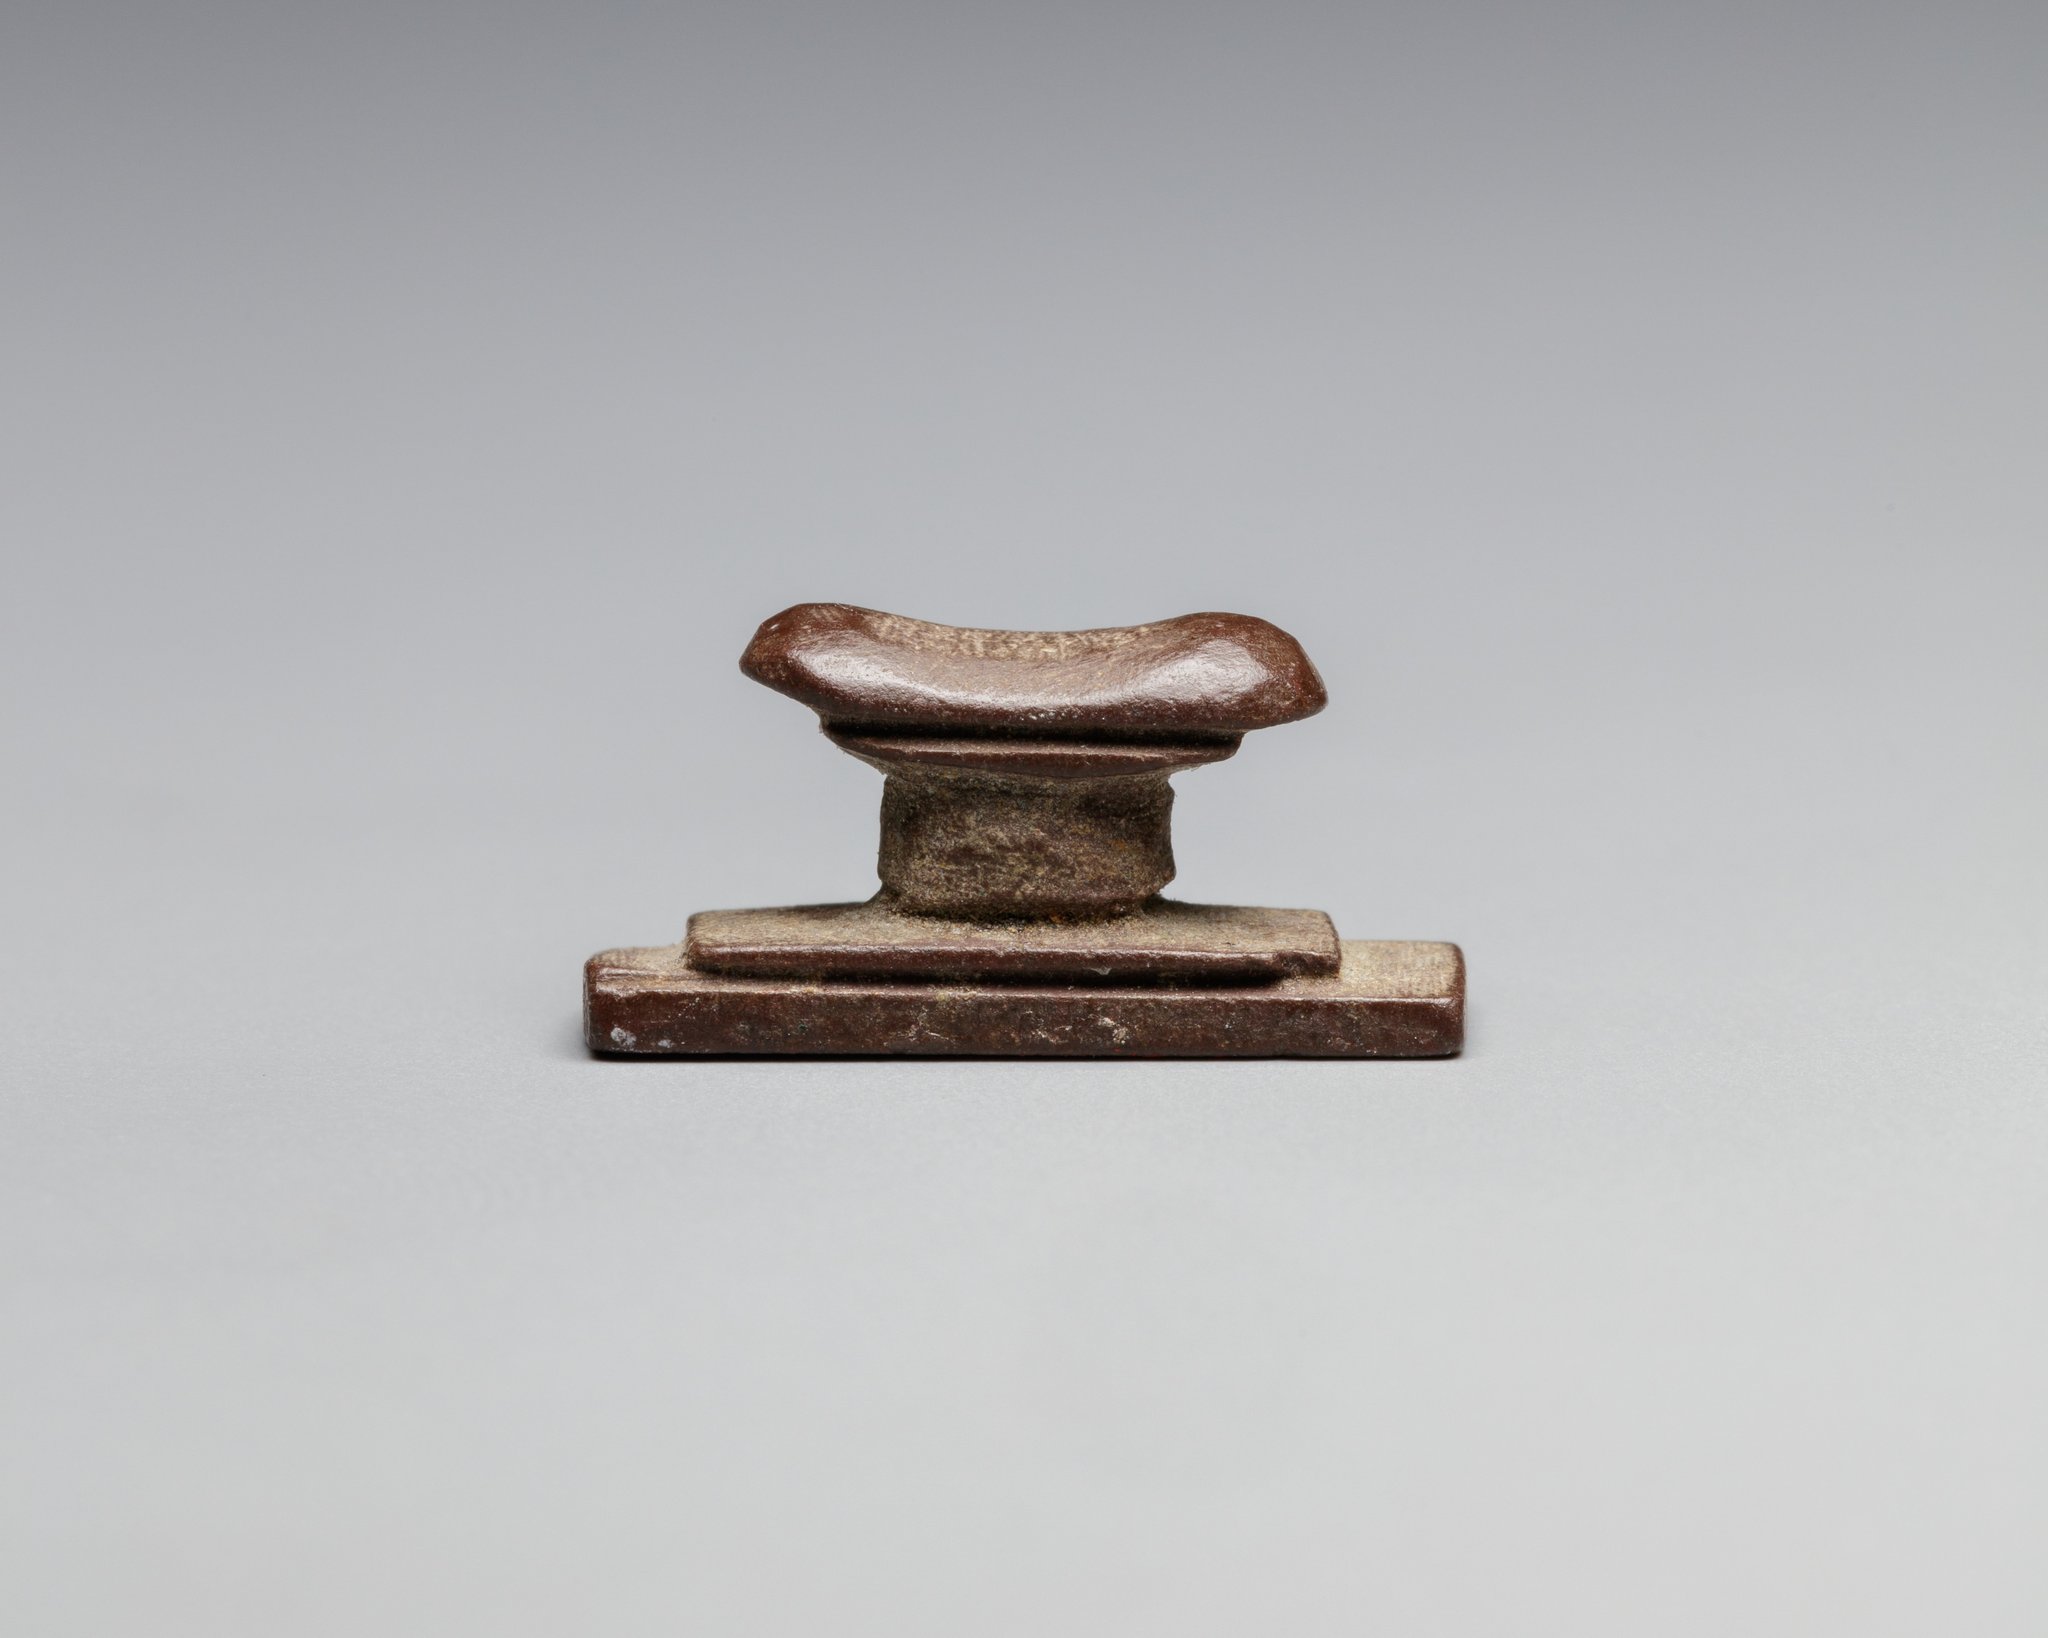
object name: amulet, headrest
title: Headrest amulet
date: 664-332 BCE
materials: stone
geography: egypt